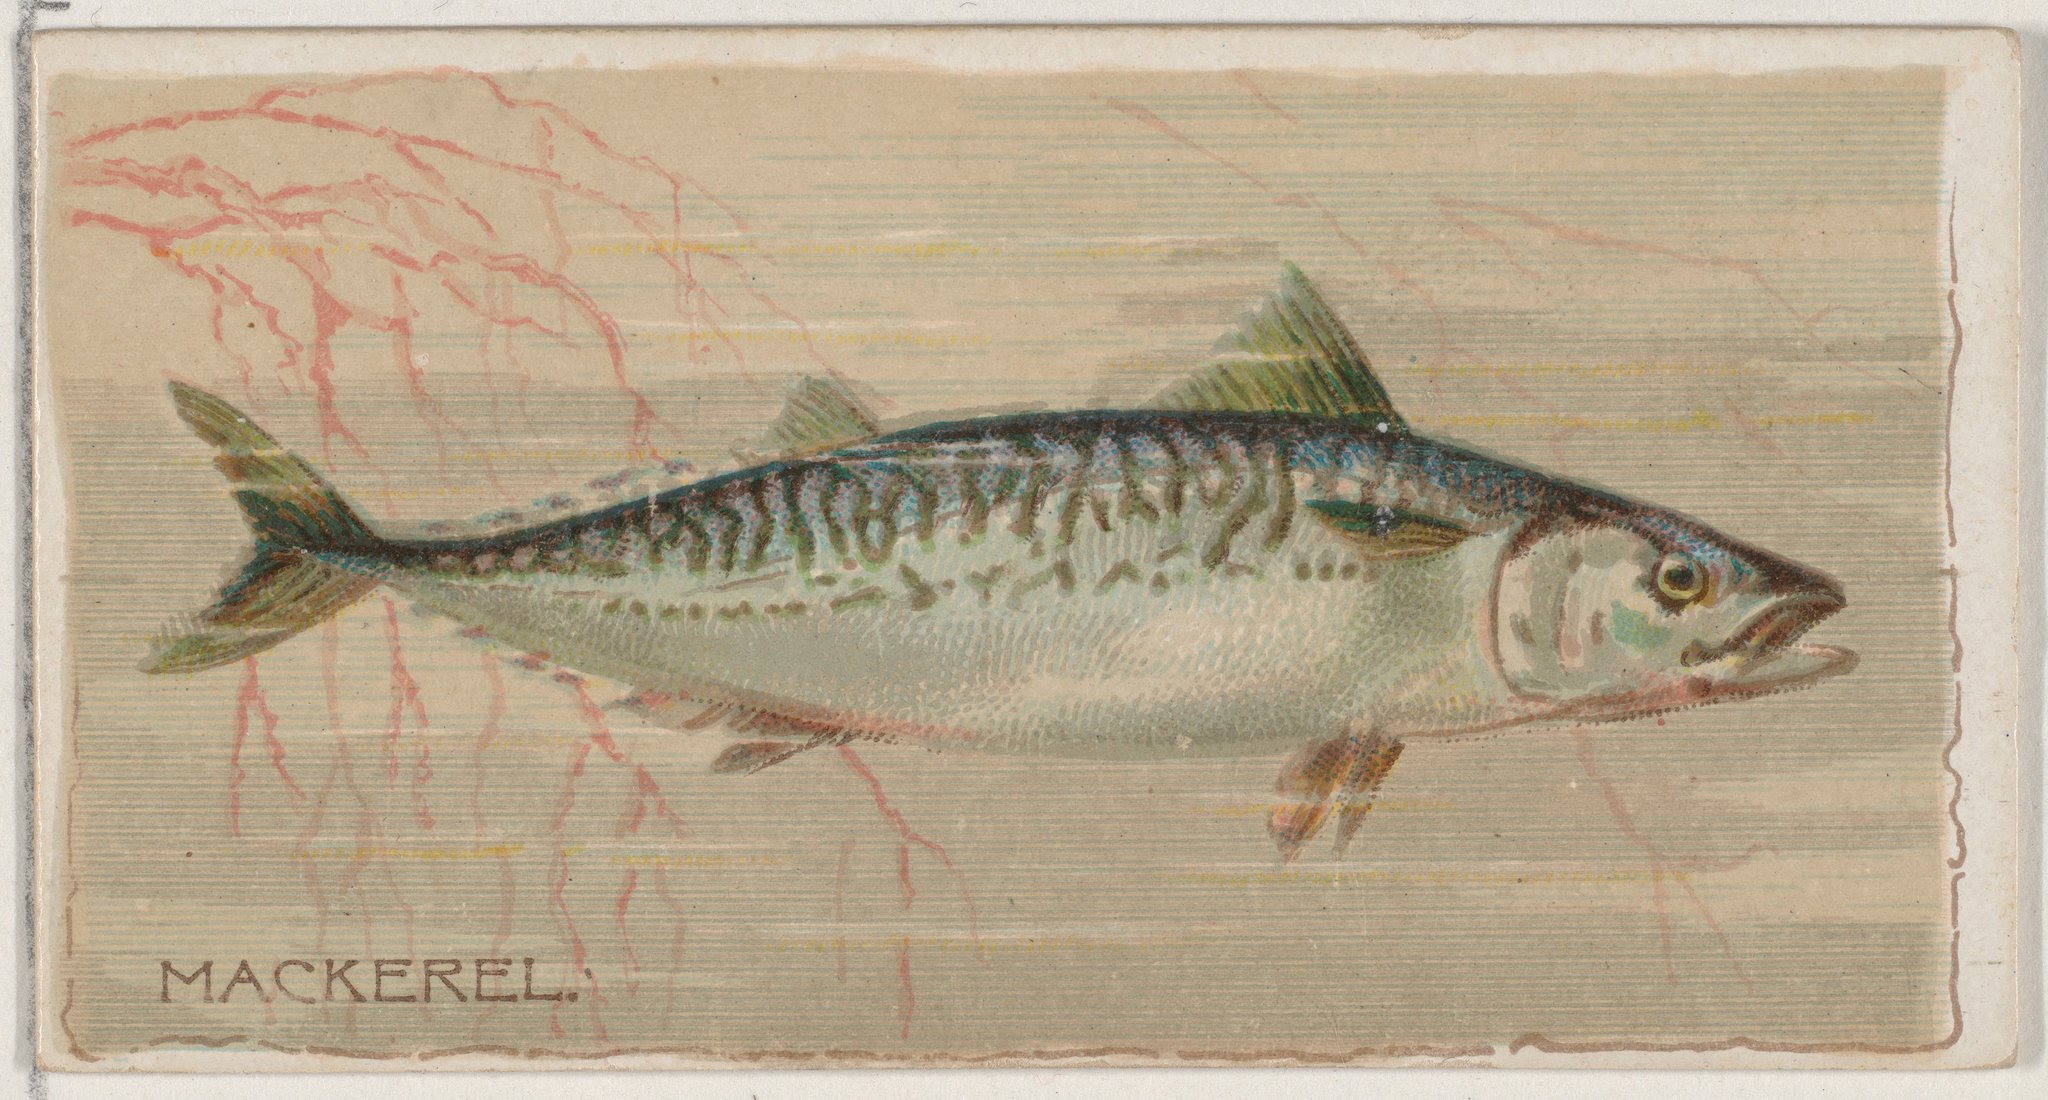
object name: print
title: Mackerel, from the series Fishers and Fish (N74) for Duke brand cigarettes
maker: knapp & company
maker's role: lithographer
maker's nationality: american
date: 1888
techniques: color lithograph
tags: fish